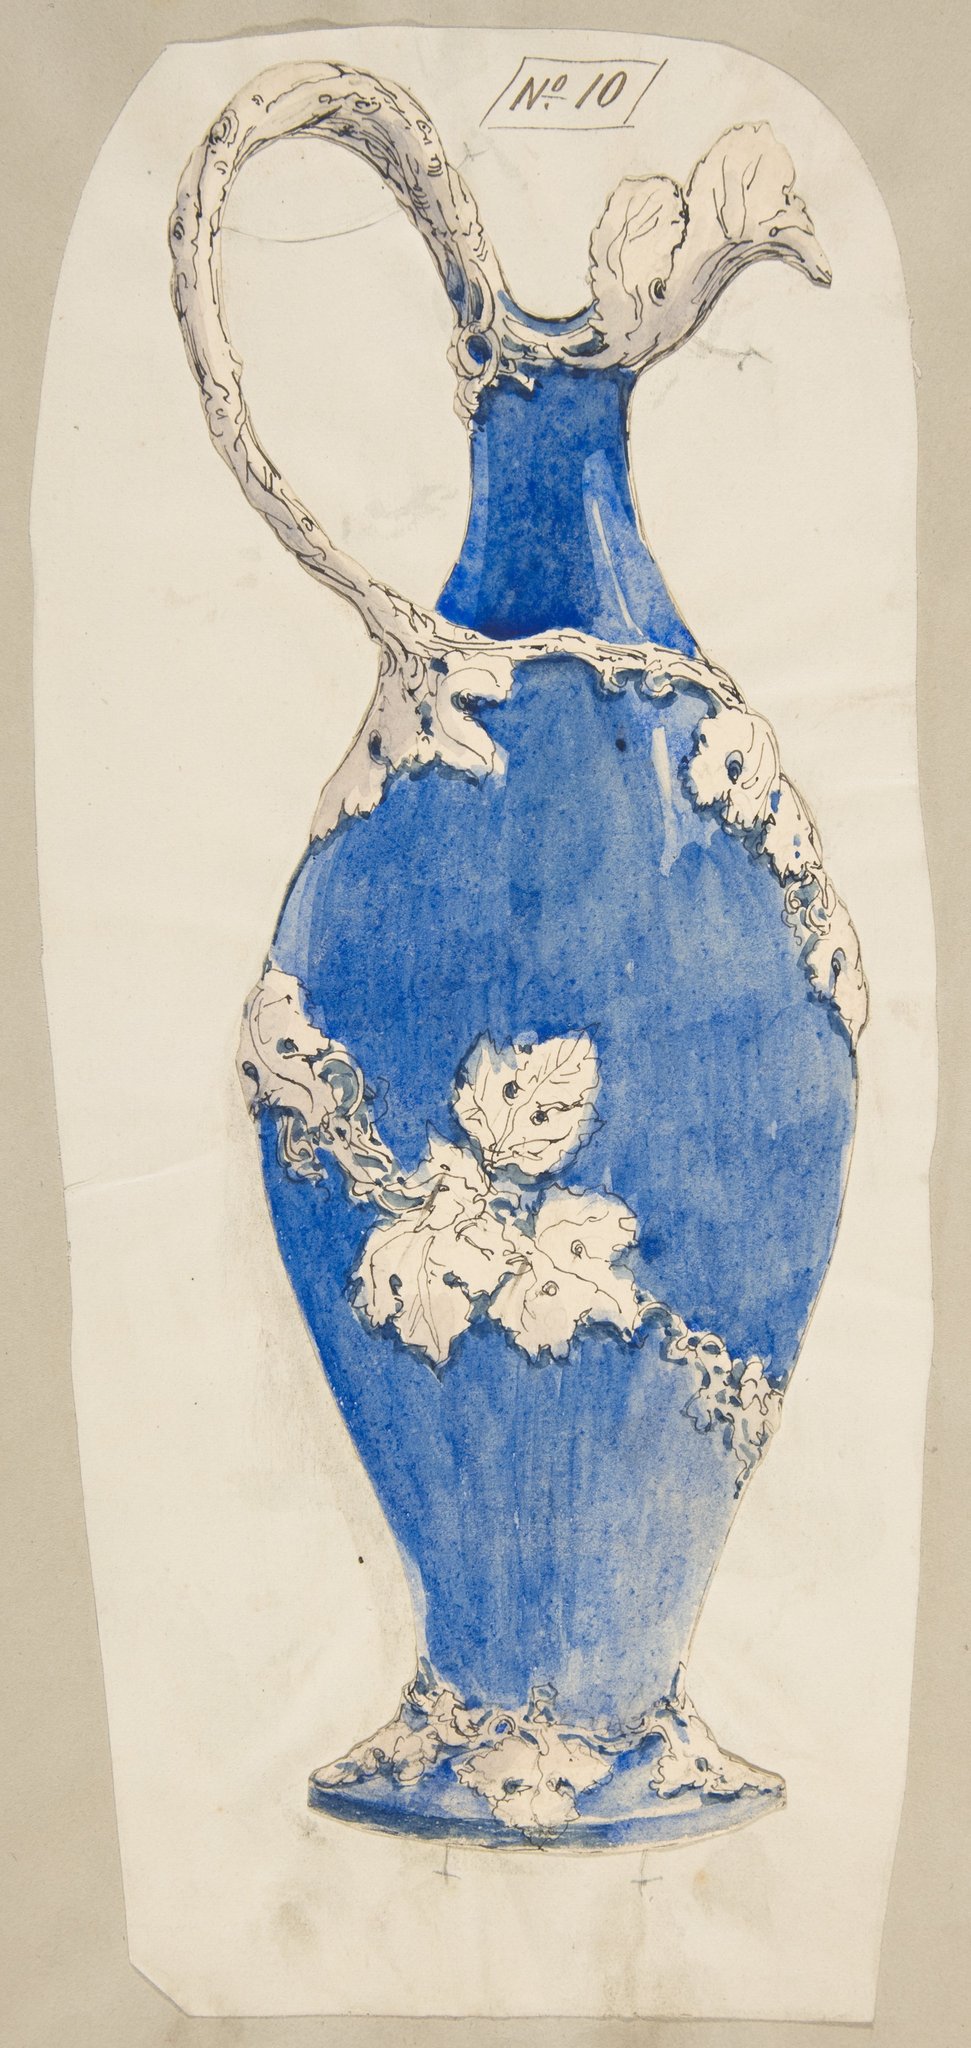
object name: drawing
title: Design for an Ewer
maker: anonymous, french, 19th century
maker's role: artist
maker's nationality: french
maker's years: 1800-1900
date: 1801-1900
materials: graphite, ink, paper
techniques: brush, pen, wash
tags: leaves,ewers